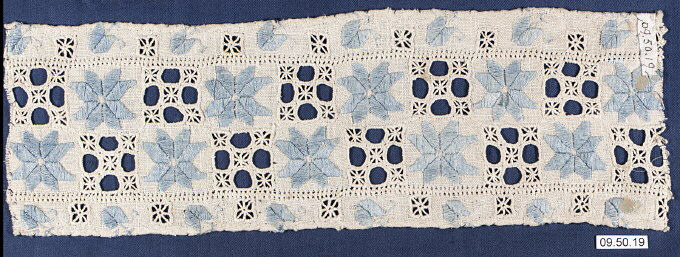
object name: strip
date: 1501-1600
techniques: embroidery